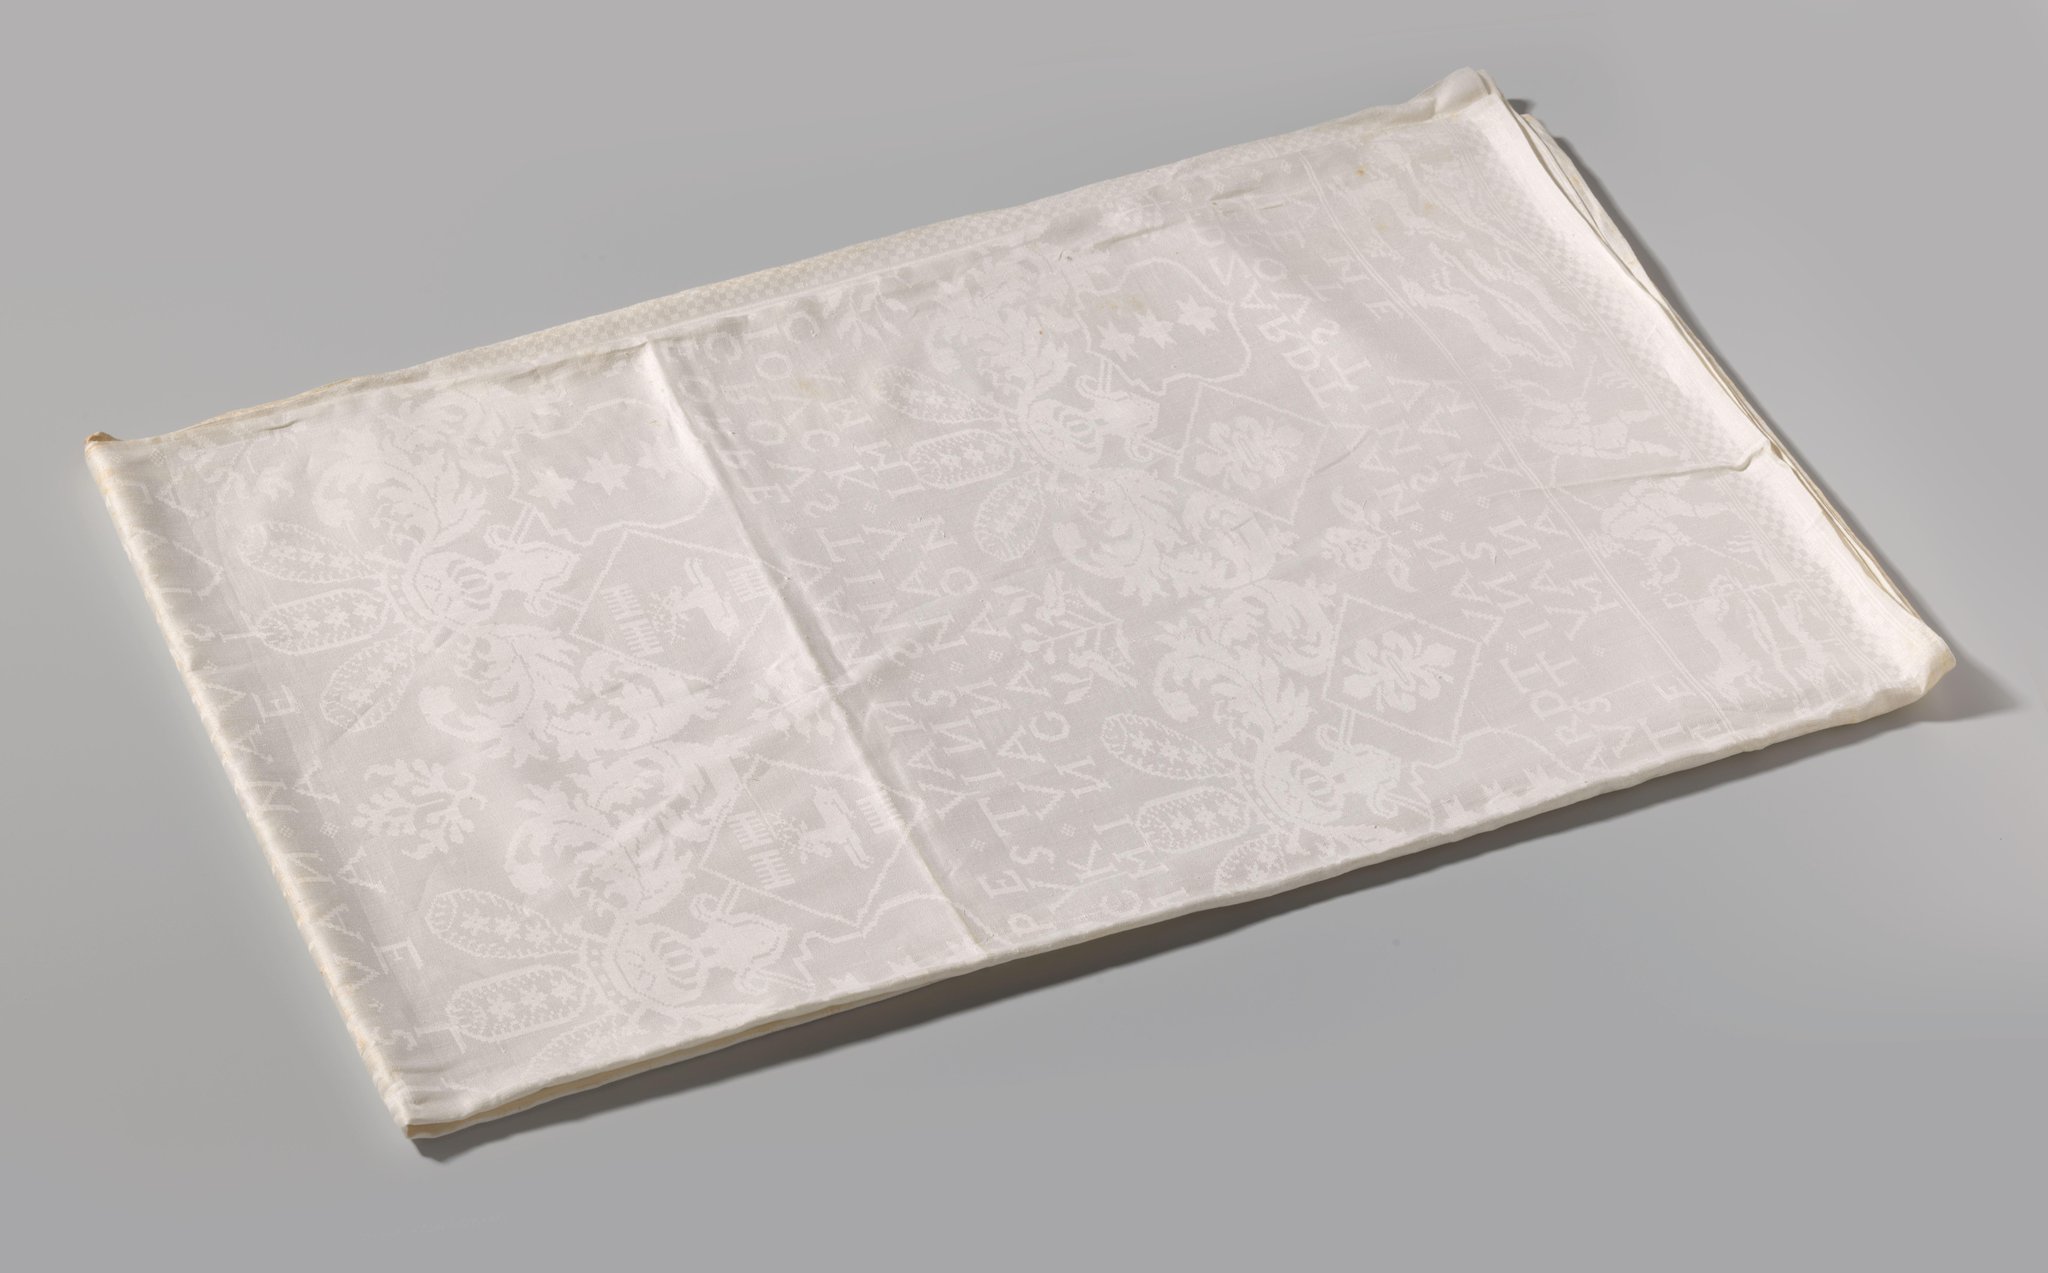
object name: tablecloth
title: Tafellaken met Friese wapens en Orpheus te midden van de dieren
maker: quirijn jansz. damast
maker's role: mayor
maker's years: 1580-1638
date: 1642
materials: linen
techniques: damask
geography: haarlem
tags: friesland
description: Tafellaken van linnendamast met Friese wapens. Middenveld: Het driemaal in de breedte herhaalde patroon vertoont de volgende taferelen: 1 Twee wapens met het bijschrift: SICCO VAN/ CAMMINGA/ VRI EN ERFHEER/ VAN AMELANT/ CATRIIINA/ VAN HEERMA/ VROUWE VAN AMELANT. 2 twee wapens met het bijschrift: TACO VAN/ CAMMINGA/ RINS LUUINGA. 3 twee wapens met het bijschrift: JOOST VAN/ OCKINGA/ SAPCK VAN/ CAMMINGA. 4 Twee wapens met het bijschrift: SICCO VAN/ CAMMINCA/ FED VAN OCKINGA. 5 Twee wapens met het bijschrift: TACO VAN/ CAMMIGA/ LUCIA VAN/ GROUSTINS. Het patroon verandert van richting en begint aan de korte zijde met wapens van de vrouwelijke lijn: 1 Twee wapens met het bijschrift: EDZARDT VAN GROUSTINS/ TET VAN UNEMA. 2 Twee wapens met het bijschrift: FOPPE VAN/ GROUSTINS/ LOUCK VAN CAMMINGA. 3 Twee wapens met het bijschrift: LAES VAN/ LONGEMA/ LUTS VAN AULEA (kan spiegelbeeldig zijn voor AELVA). 4 Twee wapens met het bijschrift: EDZARDT VAN/ GROUSTINS/ TET VAN/ UNEMA. Staande randen: Stelpende ranken met vogels, bloemen en bladeren. Liggende randen: Hazenjacht. Hoeken: Roos.